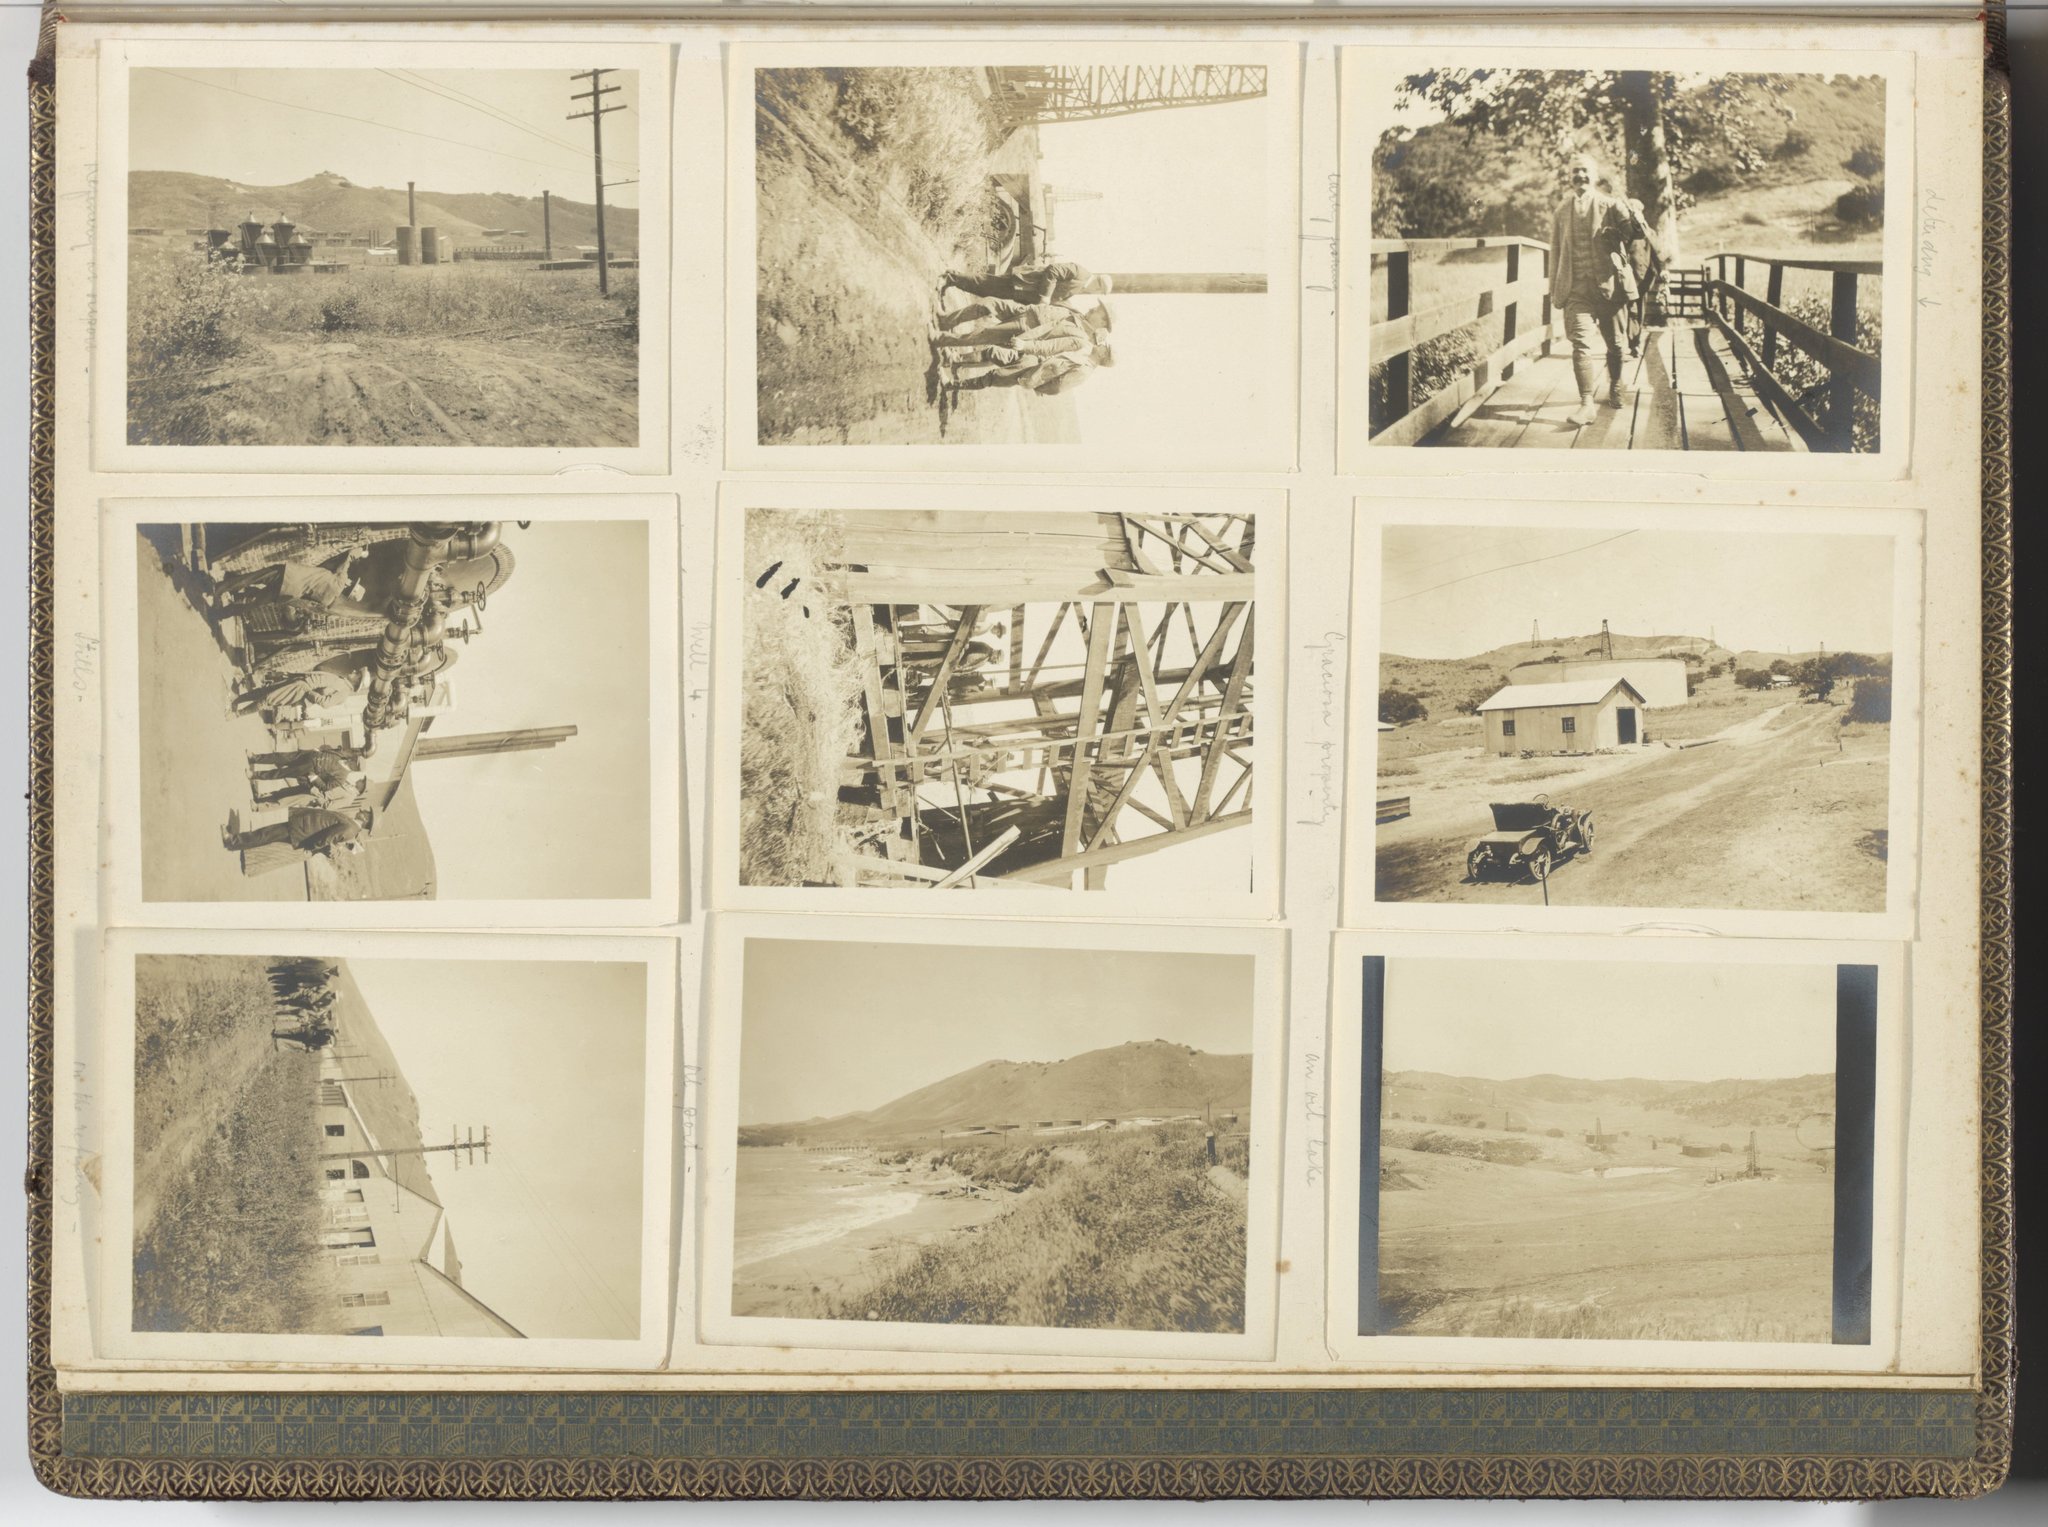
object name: photograph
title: Early fishing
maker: geldolph adriaan kessler (dolph)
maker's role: fotograaf, industrieel, voetballer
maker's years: 1884-1945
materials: cardboard, photographic support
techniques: gelatin silver print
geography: california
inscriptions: title: ‘Early fishing’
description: Vermoedelijk Henri Deterding na het vissen, tijdens een tocht langs de olievelden in California. Onderdeel van het fotoalbum van Dolph Kessler met opnamen die hij maakte tijdens zijn verblijf in Engeland en op een wereldreis die hij als secretaris van Henri Deterding (directeur Koninklijke Olie) ondernam naar Nederlands-Indië, Japan, China en de Verenigde Staten, tussen 1906 en 1908.